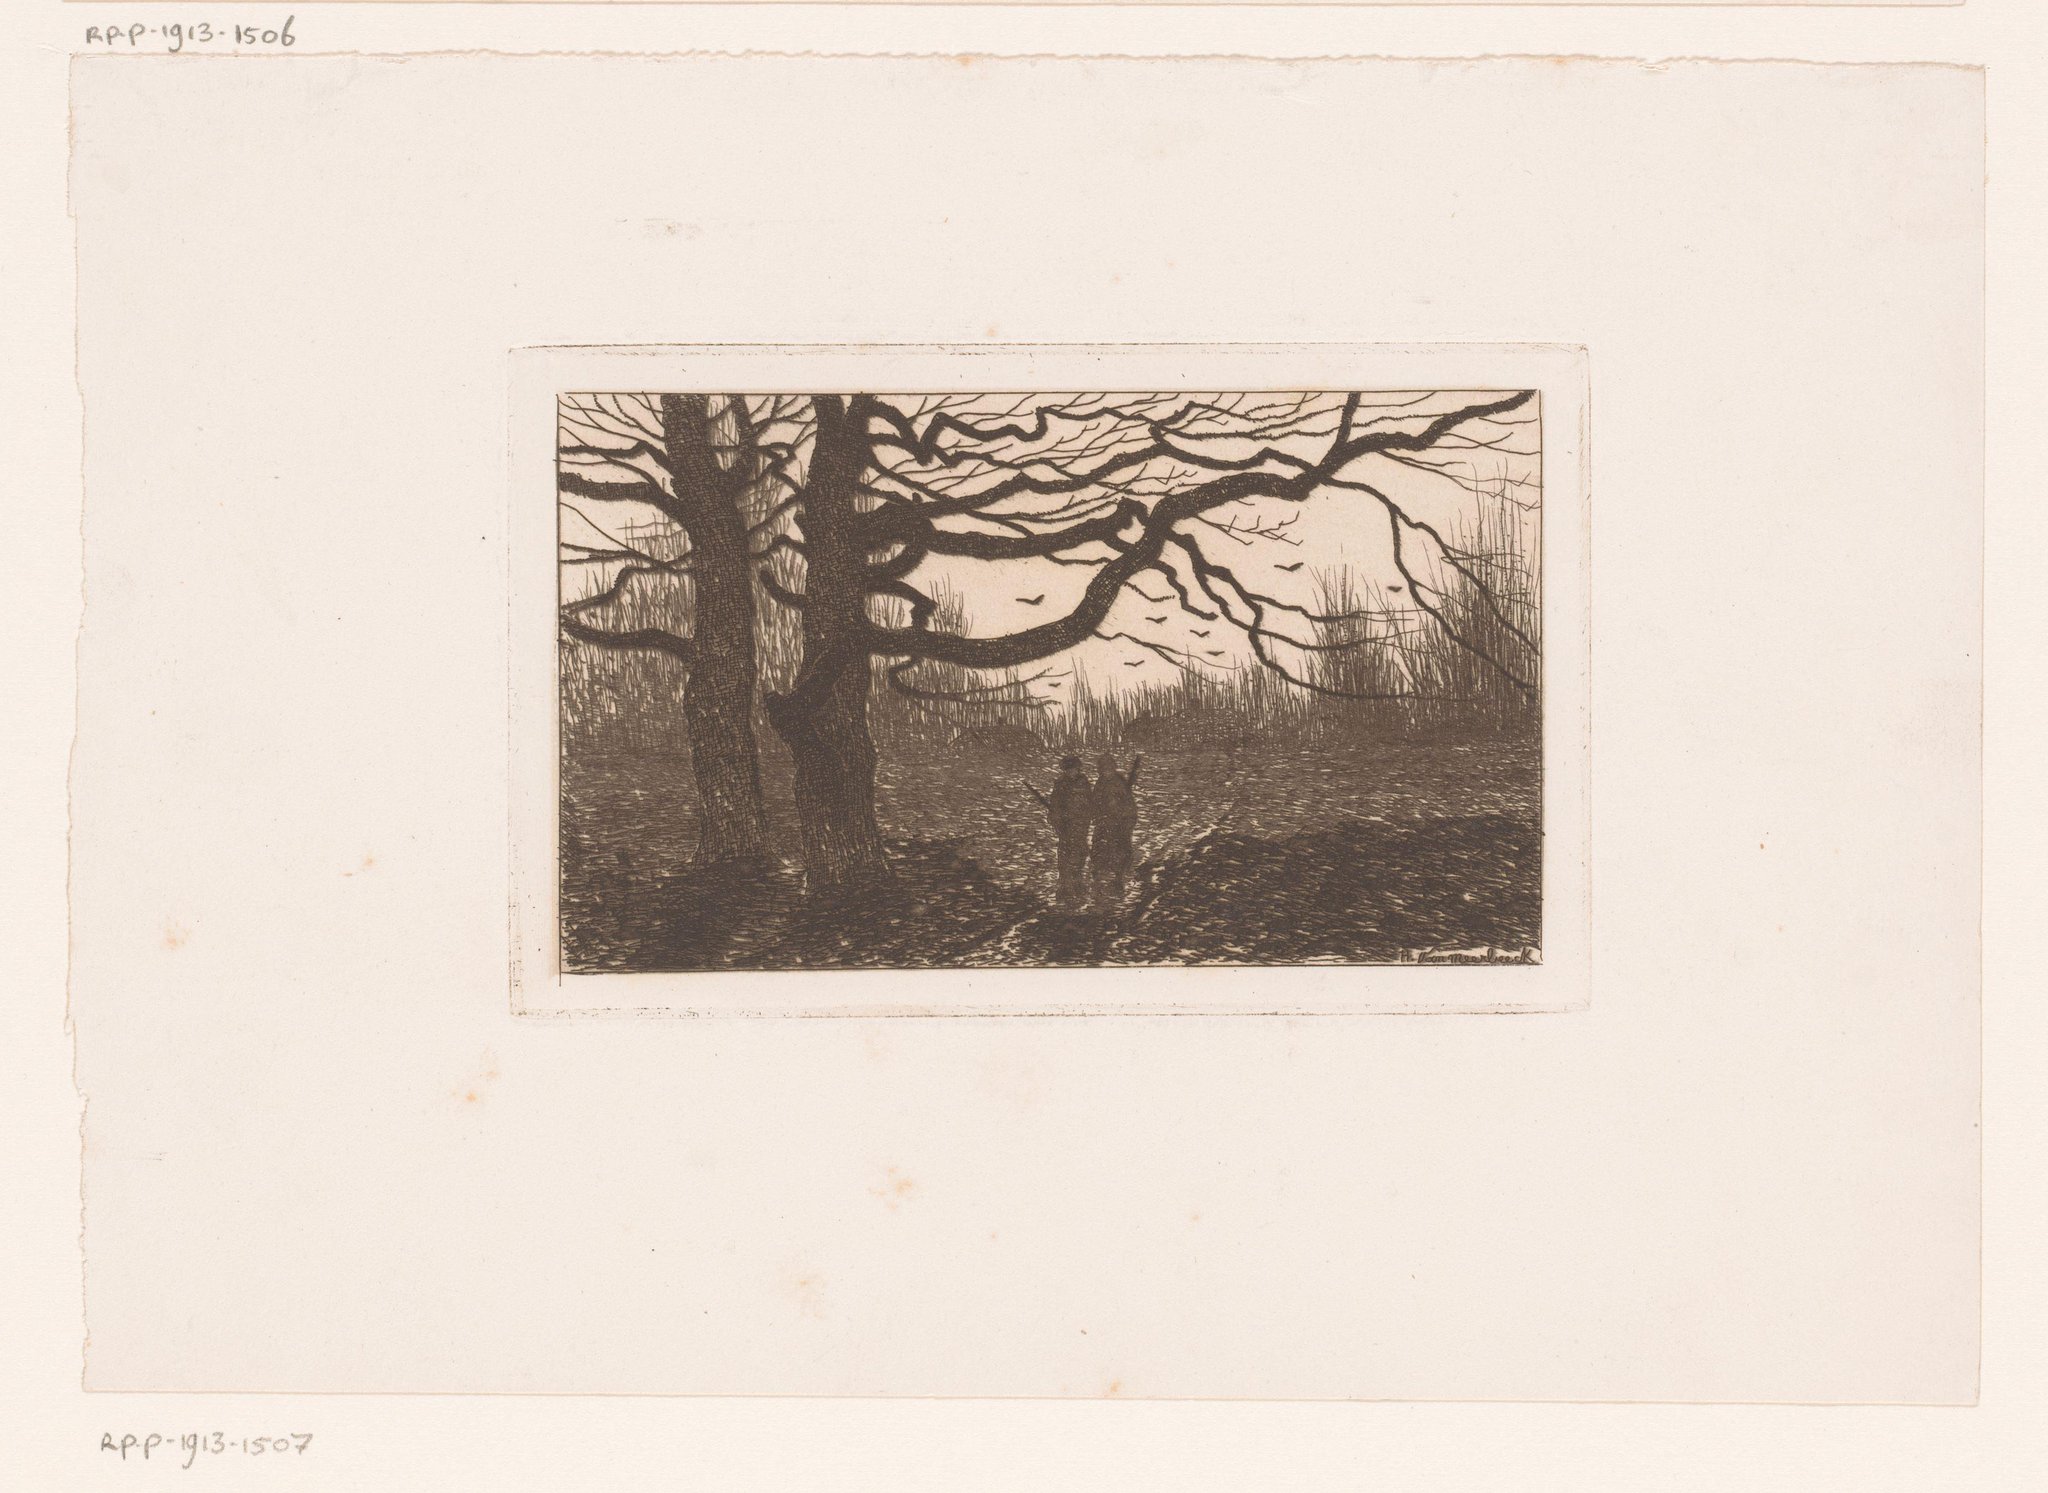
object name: print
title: Landschap met twee jagers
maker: h. van meerbeeck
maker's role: print maker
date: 1850-1913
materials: paper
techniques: etching, intaglio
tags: hunters hunting (n.b.: in 1988-1990 this notation denoted the concept of 43c11421 'hunters resting during the hunt'), landscapes (+ landscape with figures, staffage)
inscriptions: collector's mark: Lugt 2228